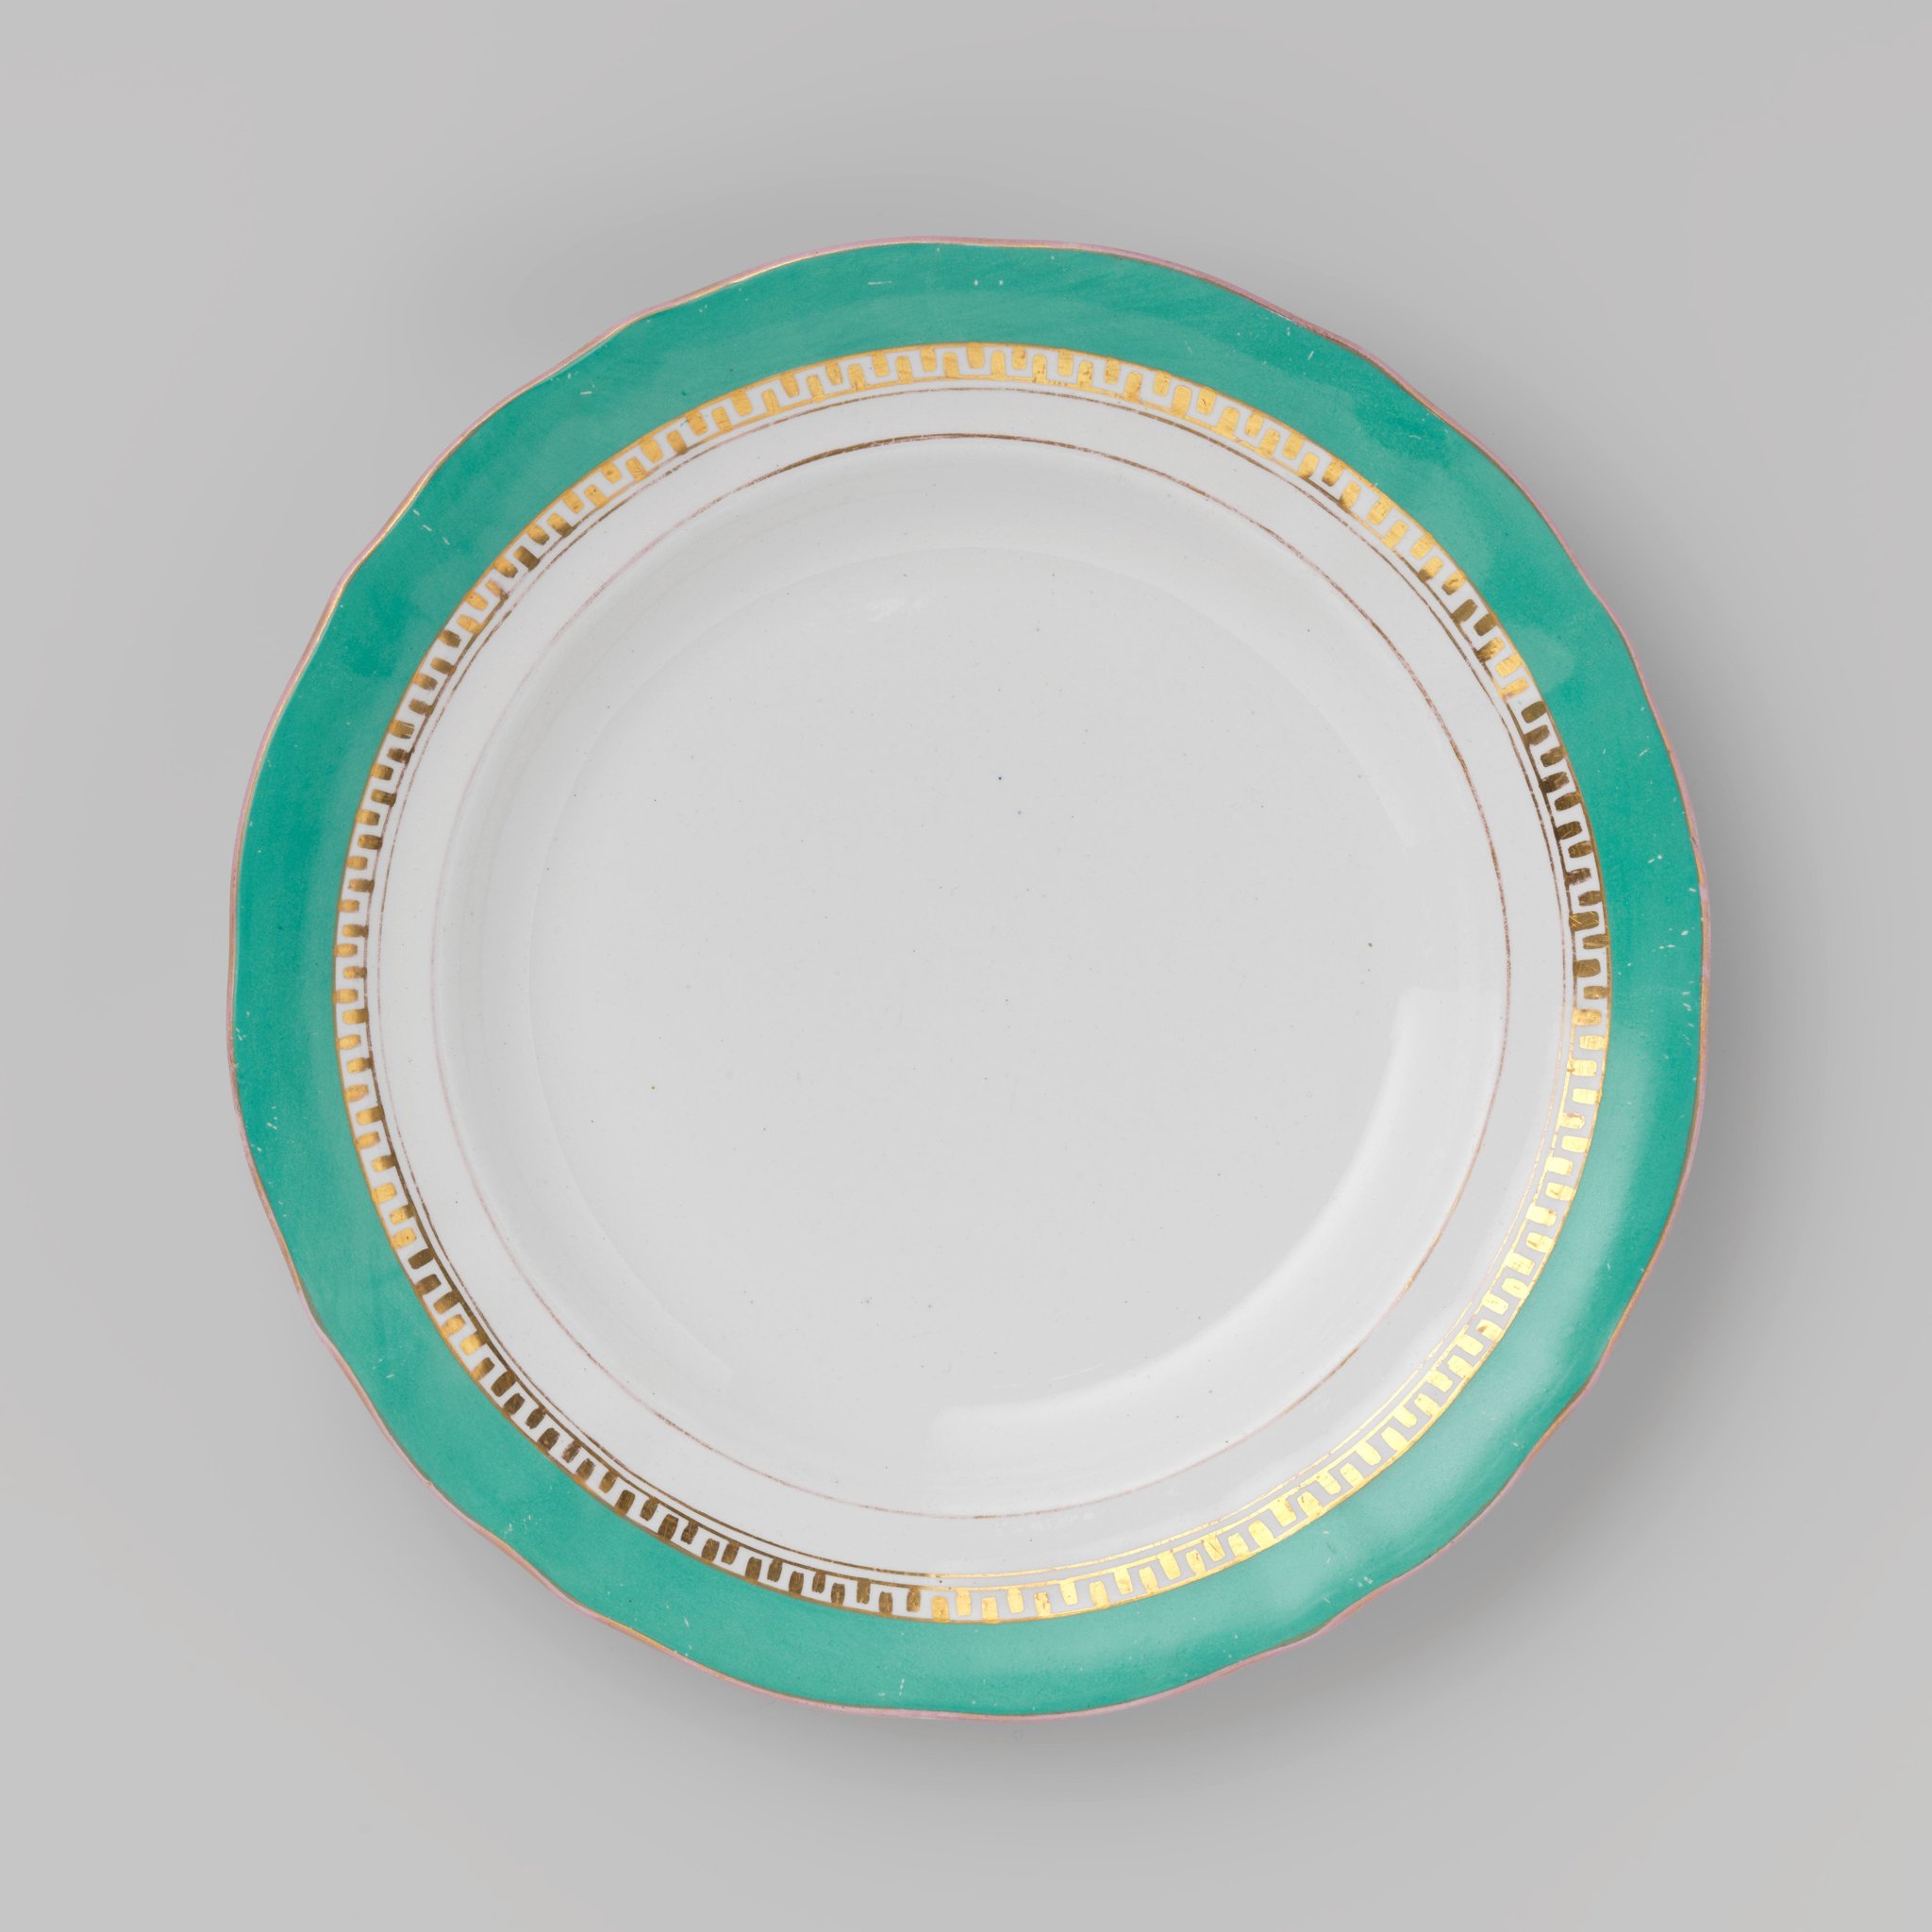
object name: plate dish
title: Bord met groene rand en gouden Griekse band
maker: petrus regout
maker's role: plateelbakker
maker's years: 1801-1879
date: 1865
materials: earthenware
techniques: transfer decoration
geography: maastricht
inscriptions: check stamp: ‘P. REGOUT // MAASTRICHT // 9X’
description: Bord van aardewerk, geschulpt, met groene rand en gouden Griekse band.